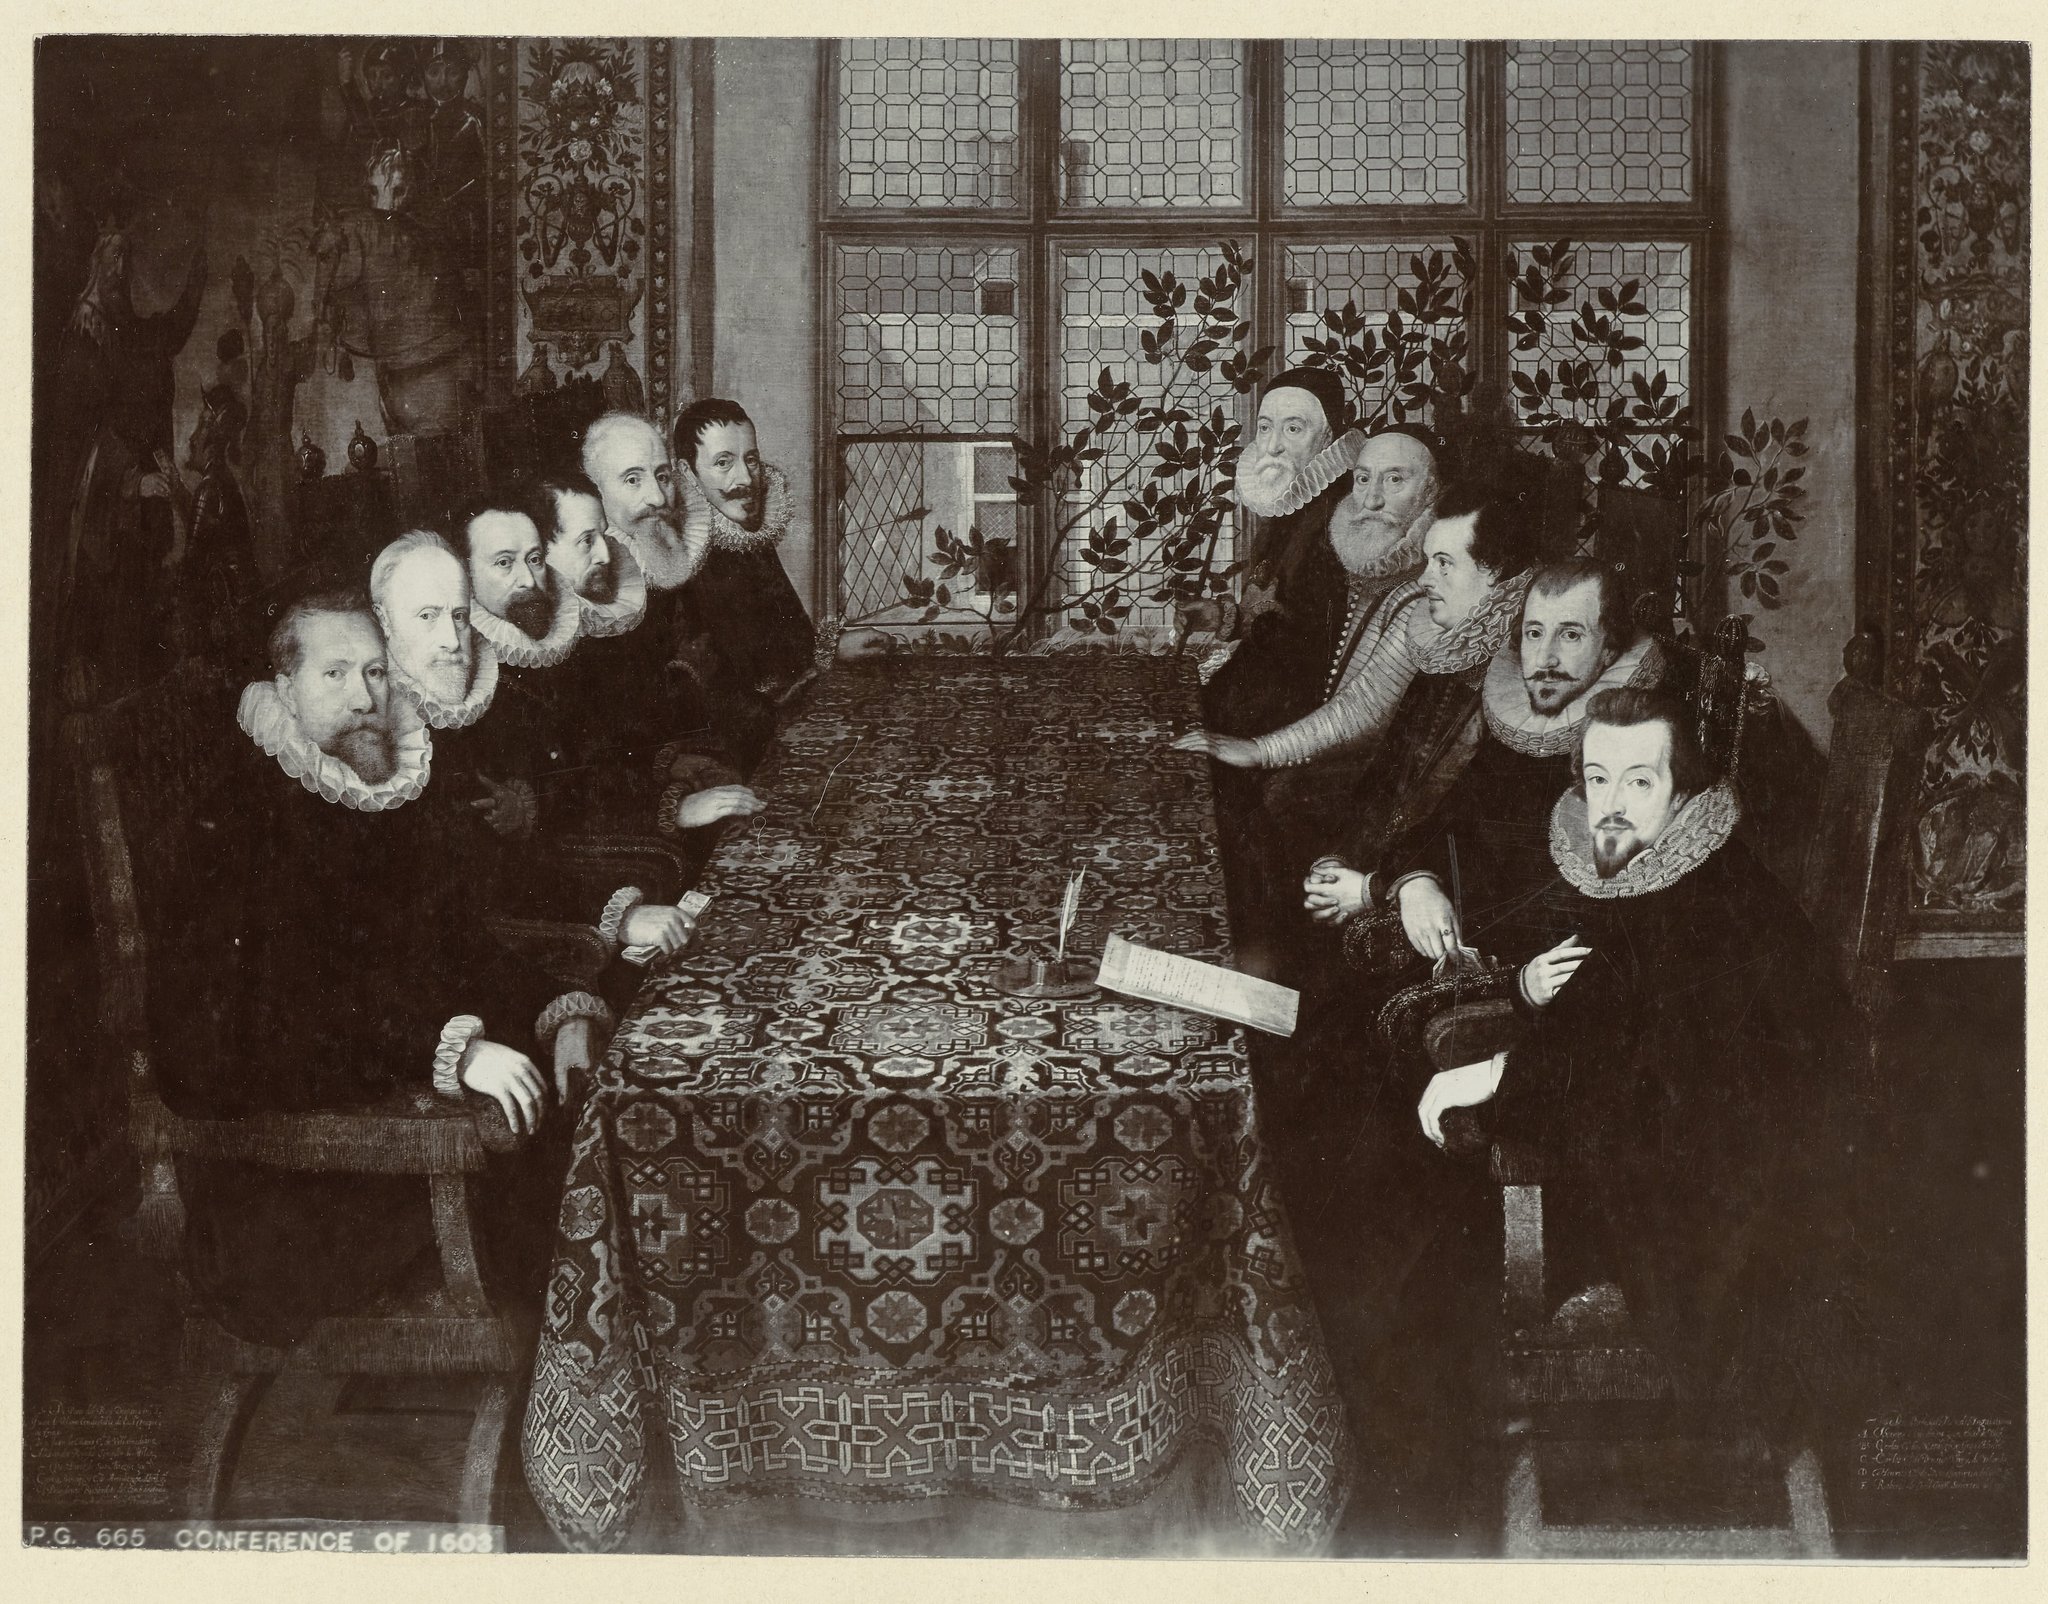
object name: photograph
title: Vredesonderhandelingen tussen de Engelse en Spaanse gevolmachtigden in Somerset House te Londen, 1604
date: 1900-1949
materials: cardboard, photographic support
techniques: photography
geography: england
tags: peace negotiations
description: Vredesonderhandelingen tussen de Engelse en Spaanse gevolmachtigden in Old Somerset House te Londen, uitmondend in het Verdrag van London waarbij de oorlogshandelingen tussen Spanje en Engeland werden beëindigd. Het verdrag werd getekend op 16 augustus 1604. Foto van het anonieme schilderij in de collectie van de National Portrait Gallery te Londen.